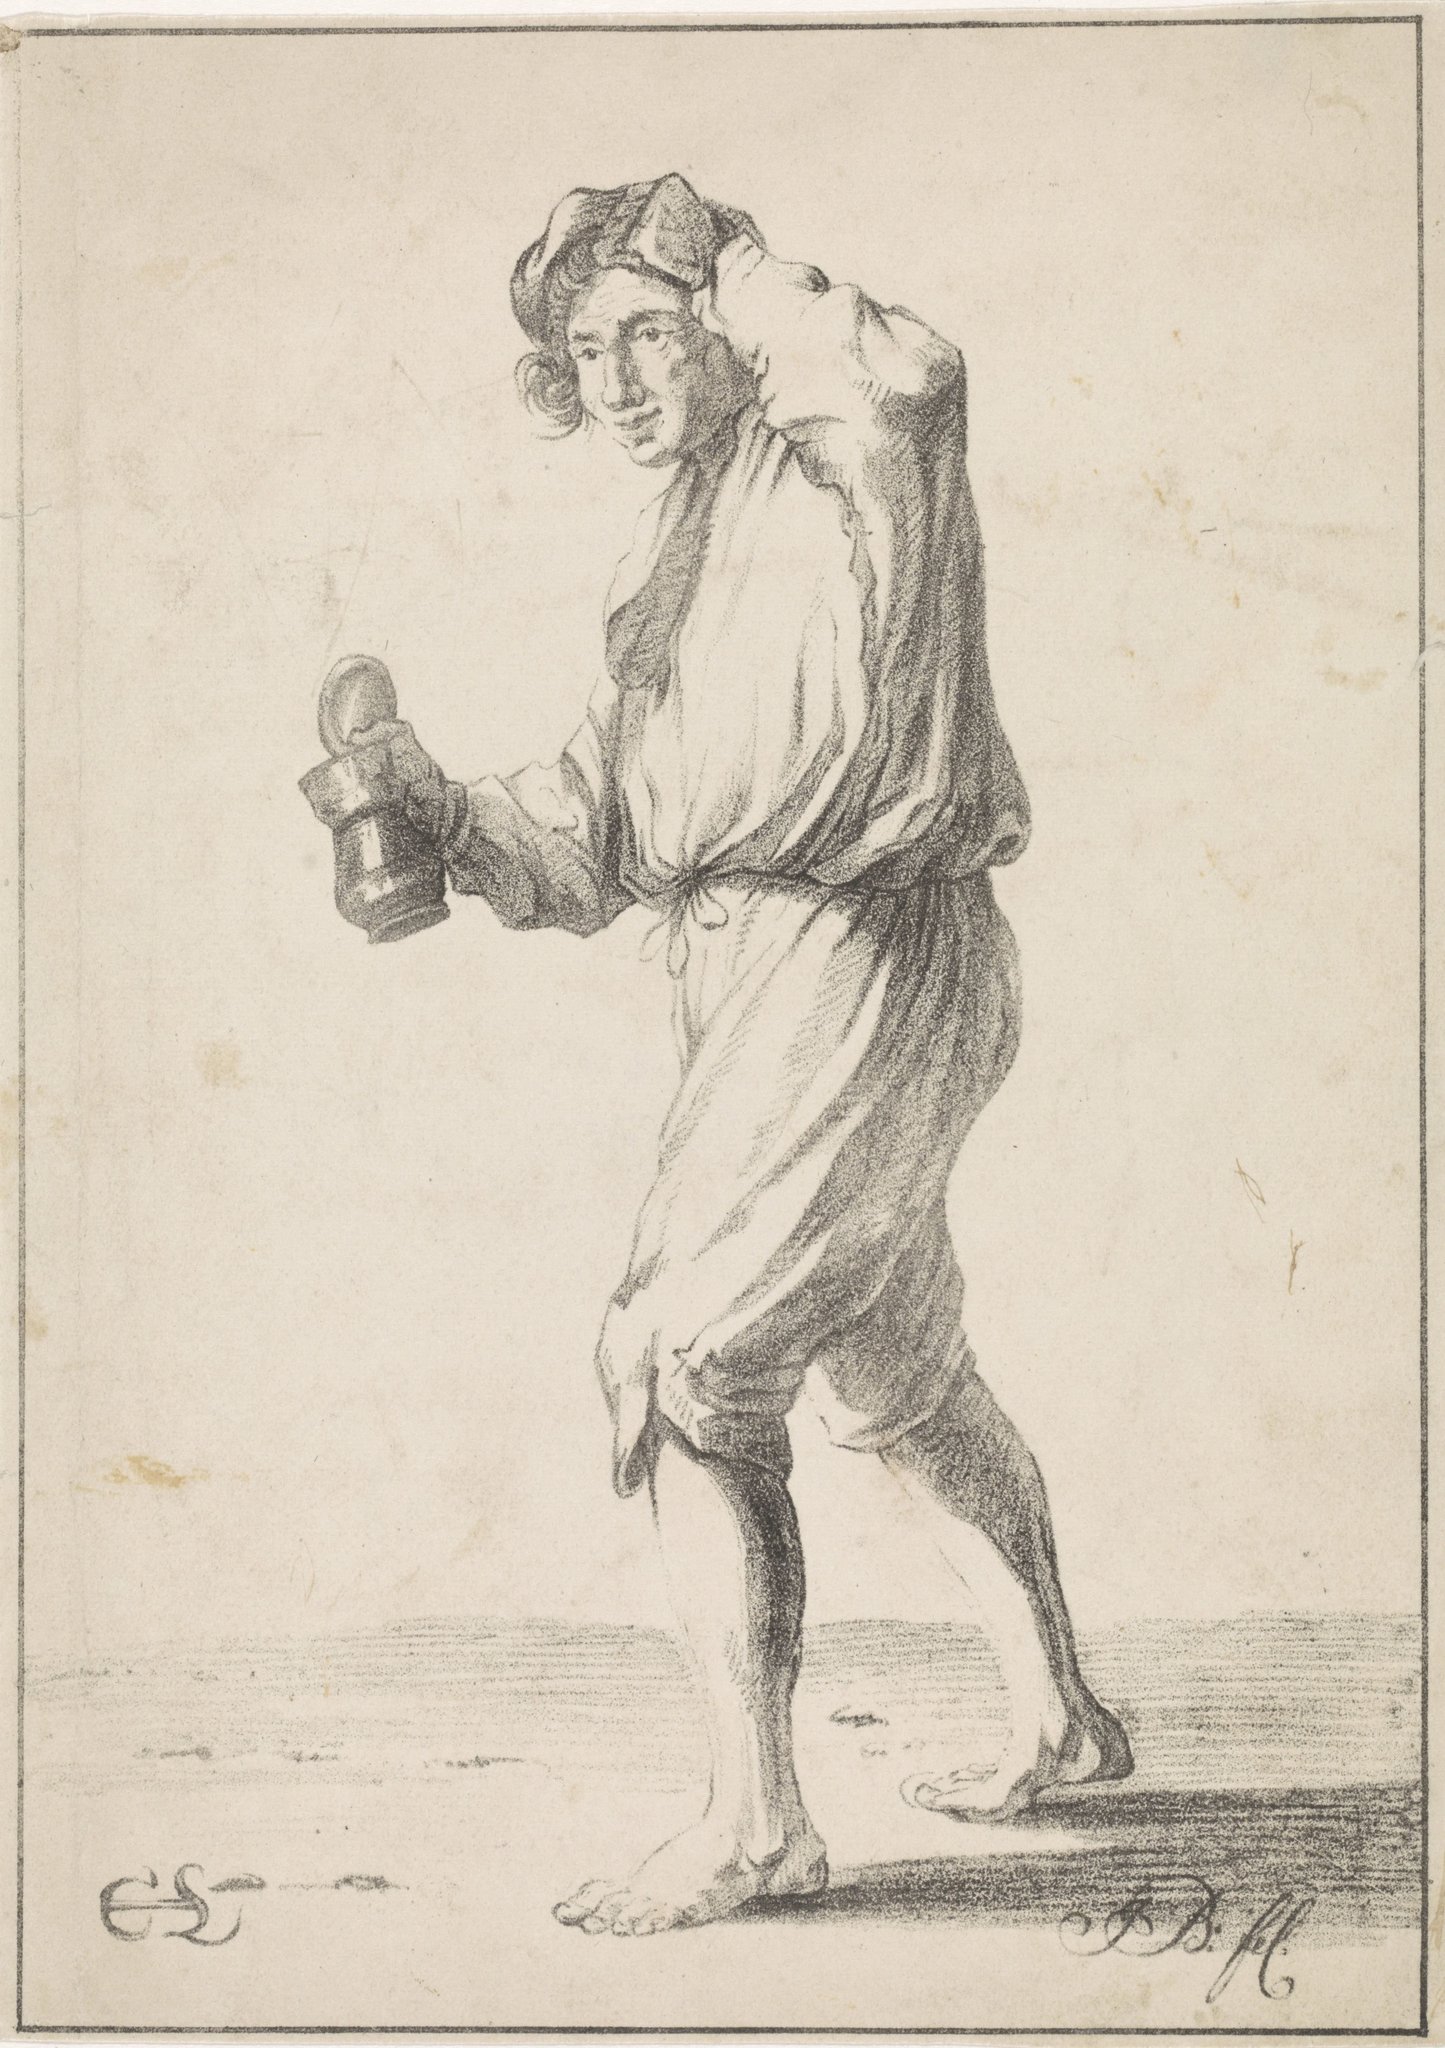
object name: print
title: Man met bierpul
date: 1809-1841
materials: paper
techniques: lithograph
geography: netherlands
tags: tankard, barefoot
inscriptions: collector's mark: Lugt 2228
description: De man heeft de pul in zijn rechterhand. Zijn linkerhand houdt hij tegen zijn voorhoofd. Hij loopt op blote voeten.